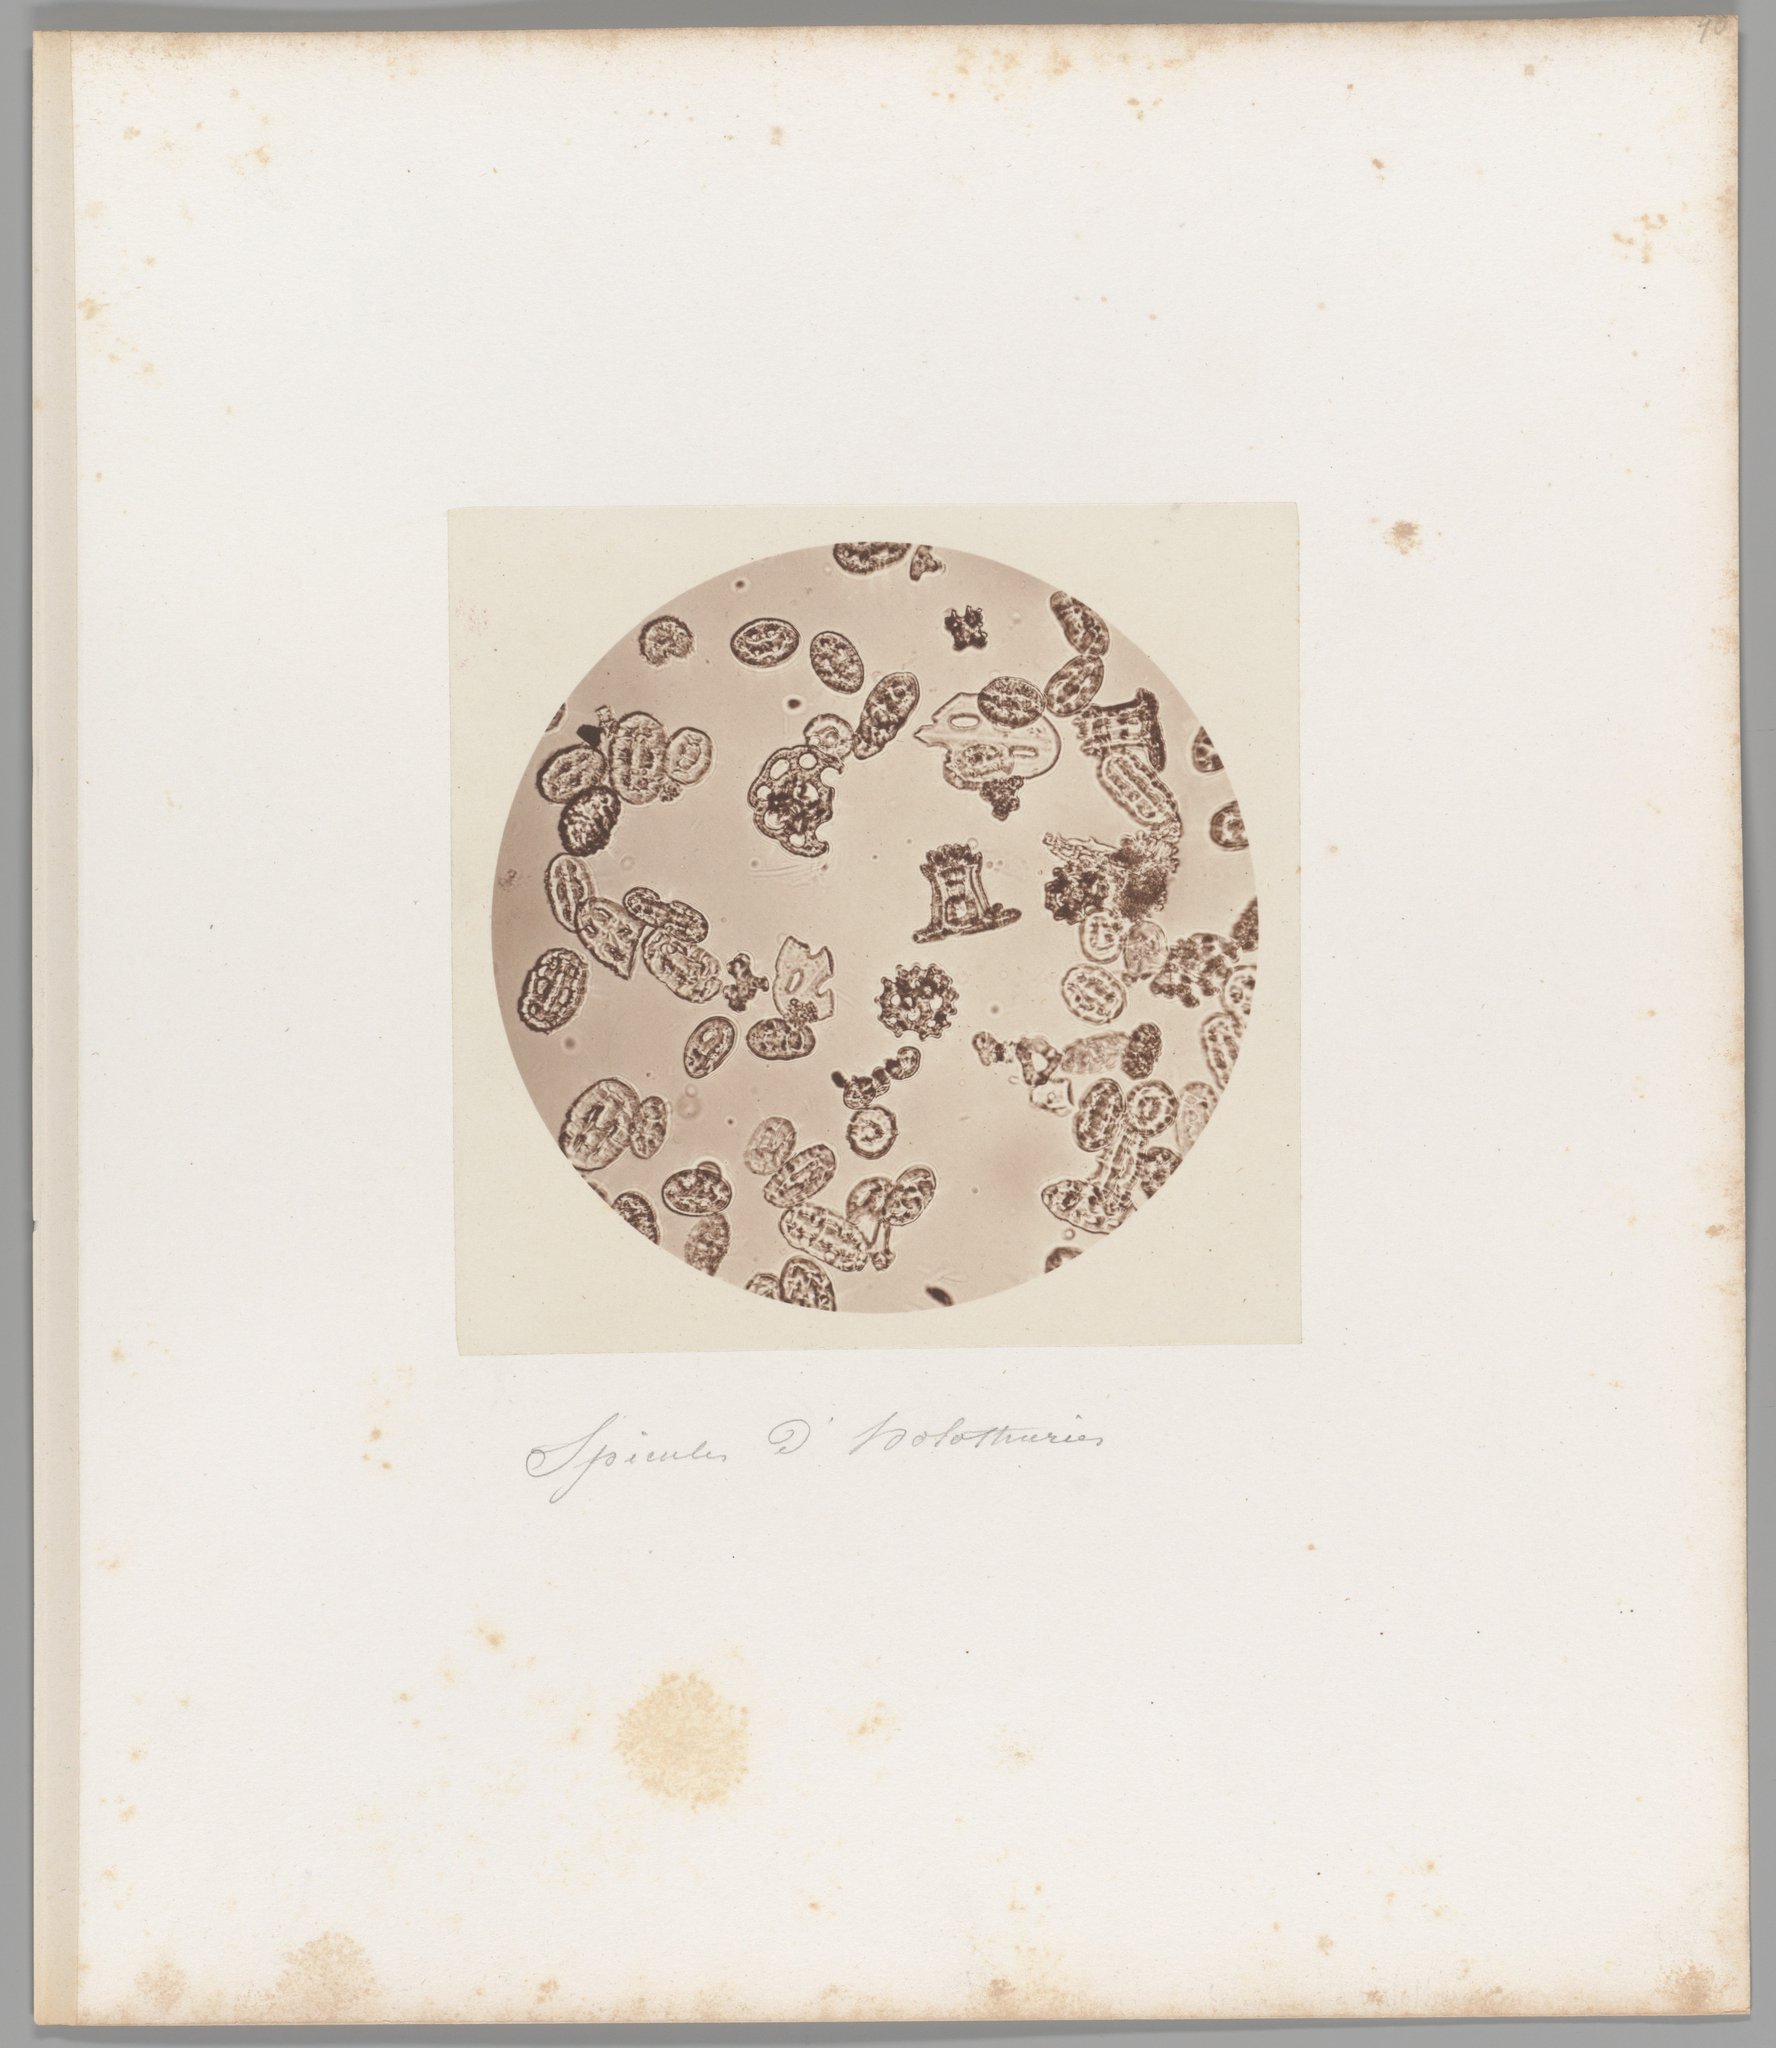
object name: photograph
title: [Untitled]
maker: auguste-adolphe bertsch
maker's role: artist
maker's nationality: french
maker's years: 1813-1871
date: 1853-1857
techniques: salted paper print